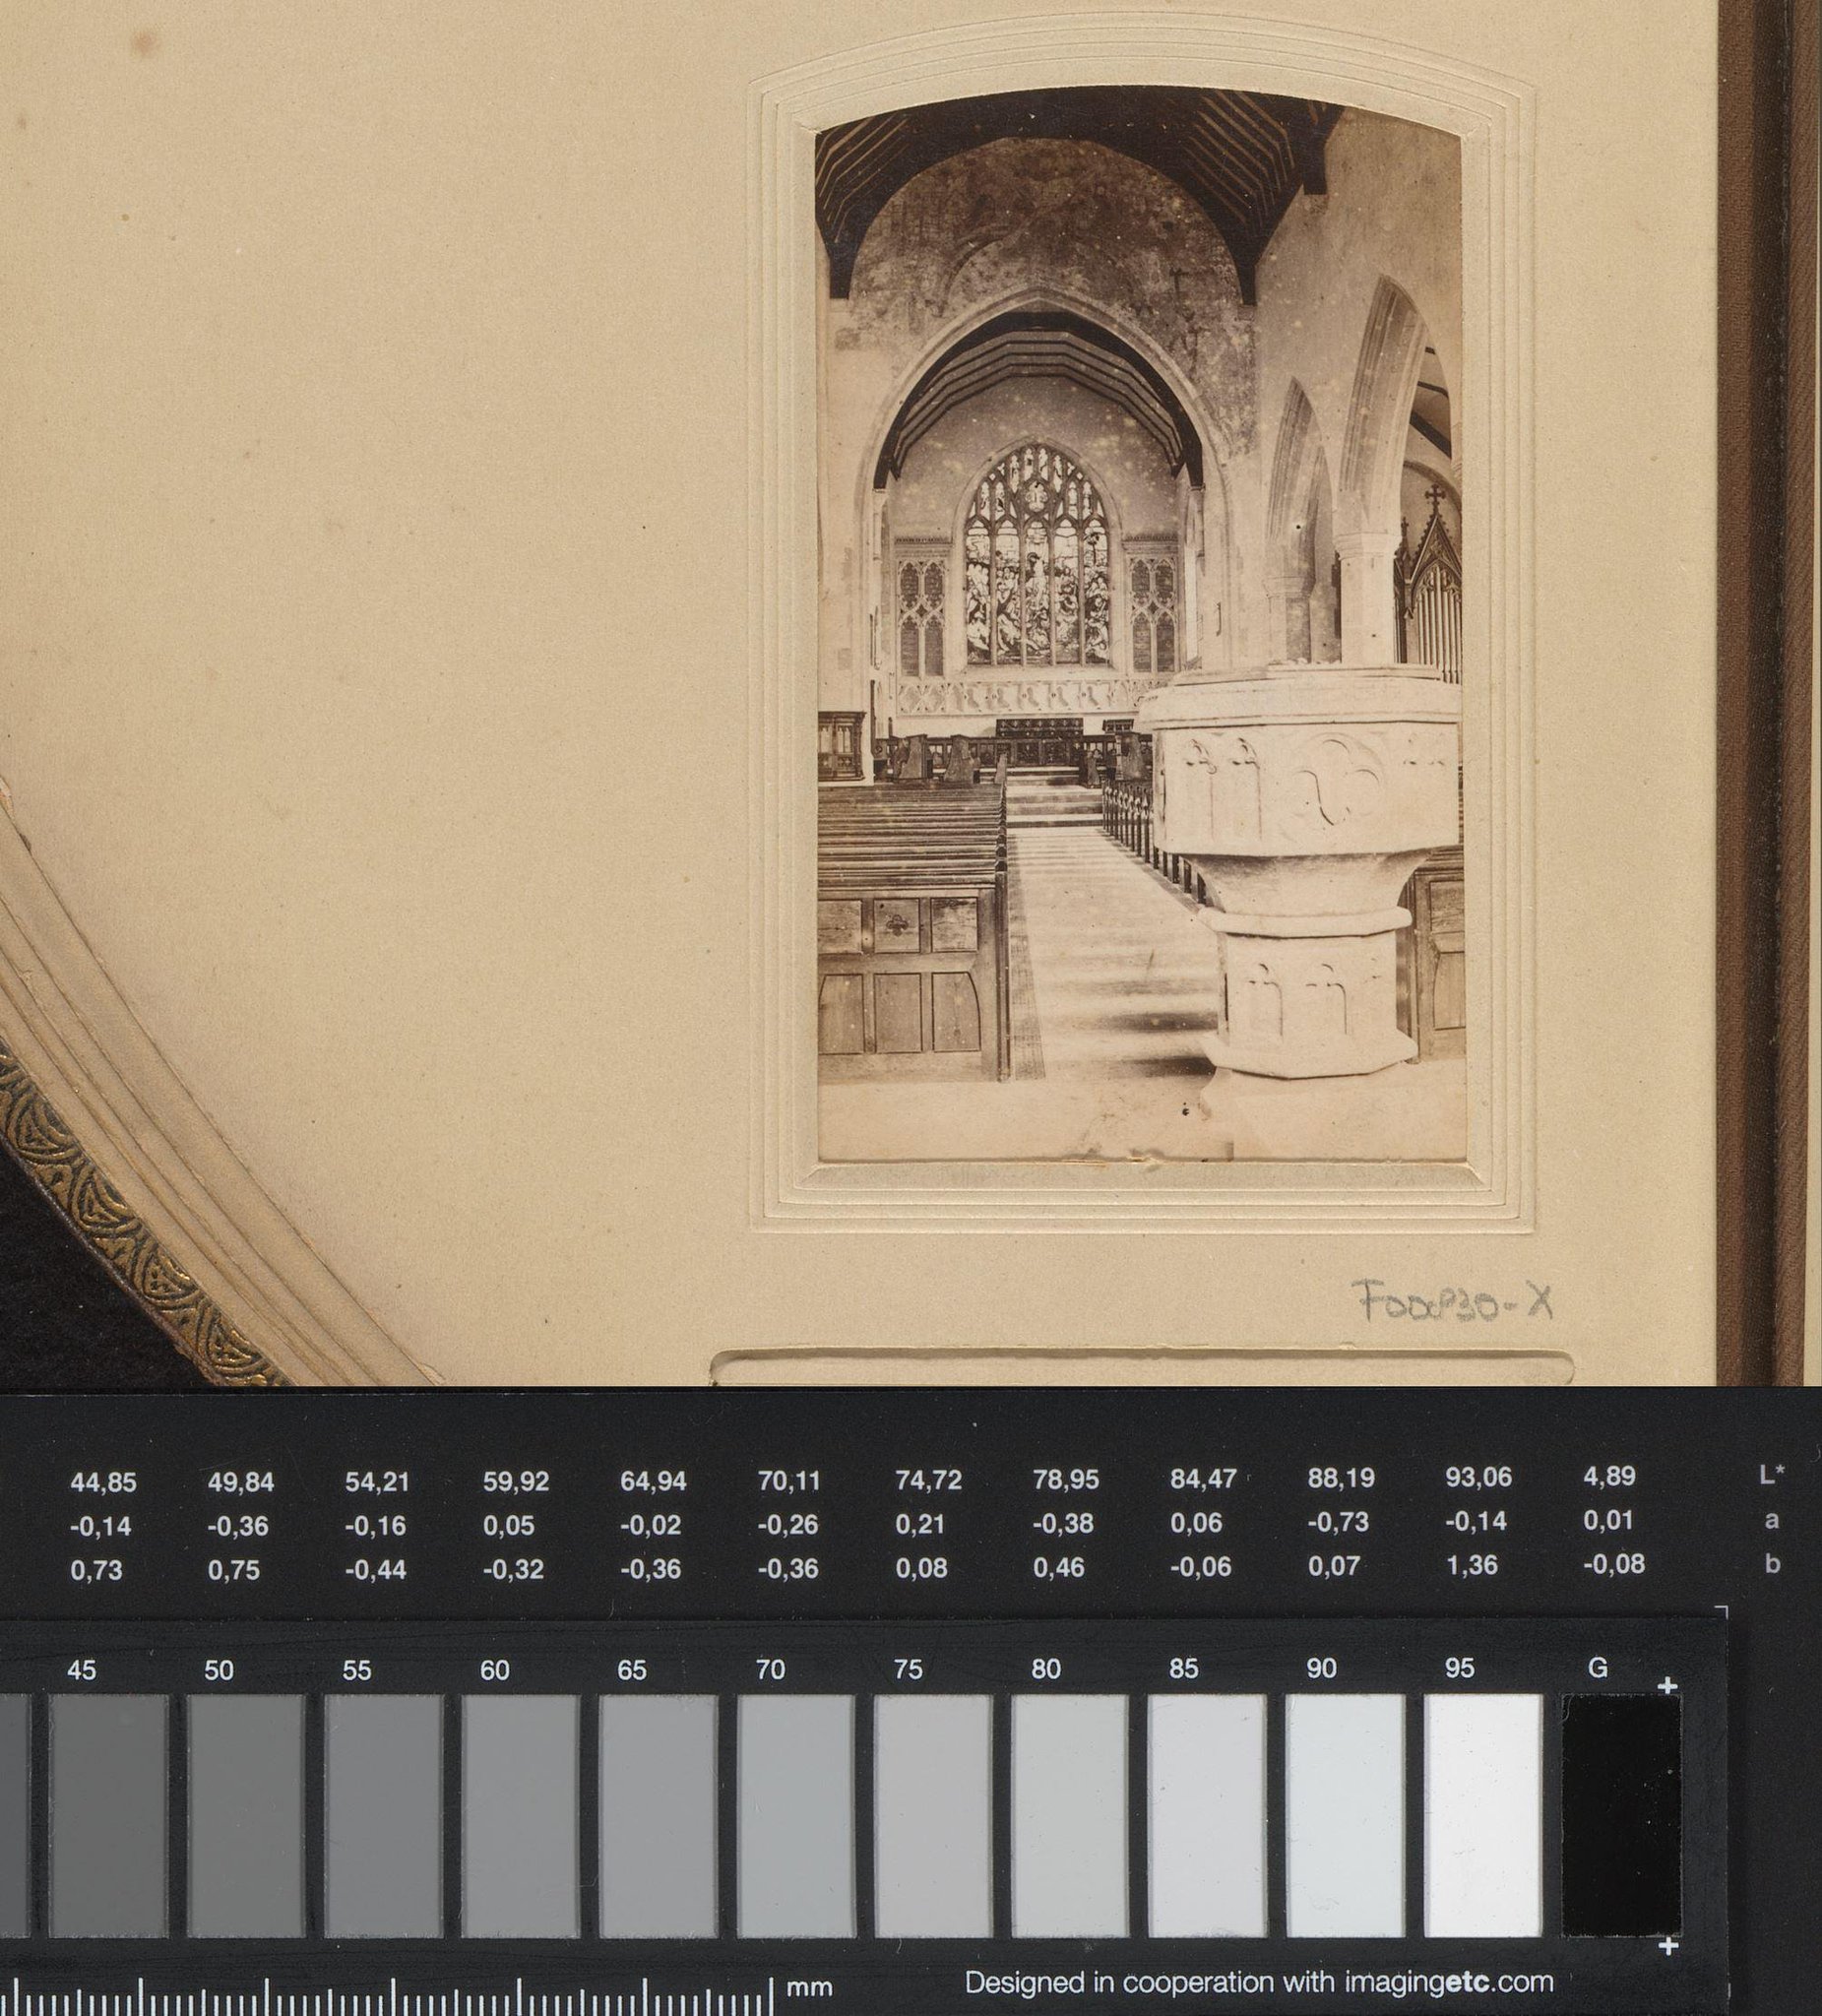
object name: photograph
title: Interieur van All Saints Church te Hastings, koor en doopvont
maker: frances sutherland mann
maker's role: fotograaf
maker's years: 1867-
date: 1880-1900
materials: cardboard, photographic support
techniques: albumen print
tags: parts of church interior: choir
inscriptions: annotation: ‘[...] All Saints Ch’, annotation: ‘Chancil [...]/ All Saints Ch’, inscription: ‘F. S. Mann/ phototgraphic/ artist/ 13/ Wellington/ place/ Hastings/ (...)’